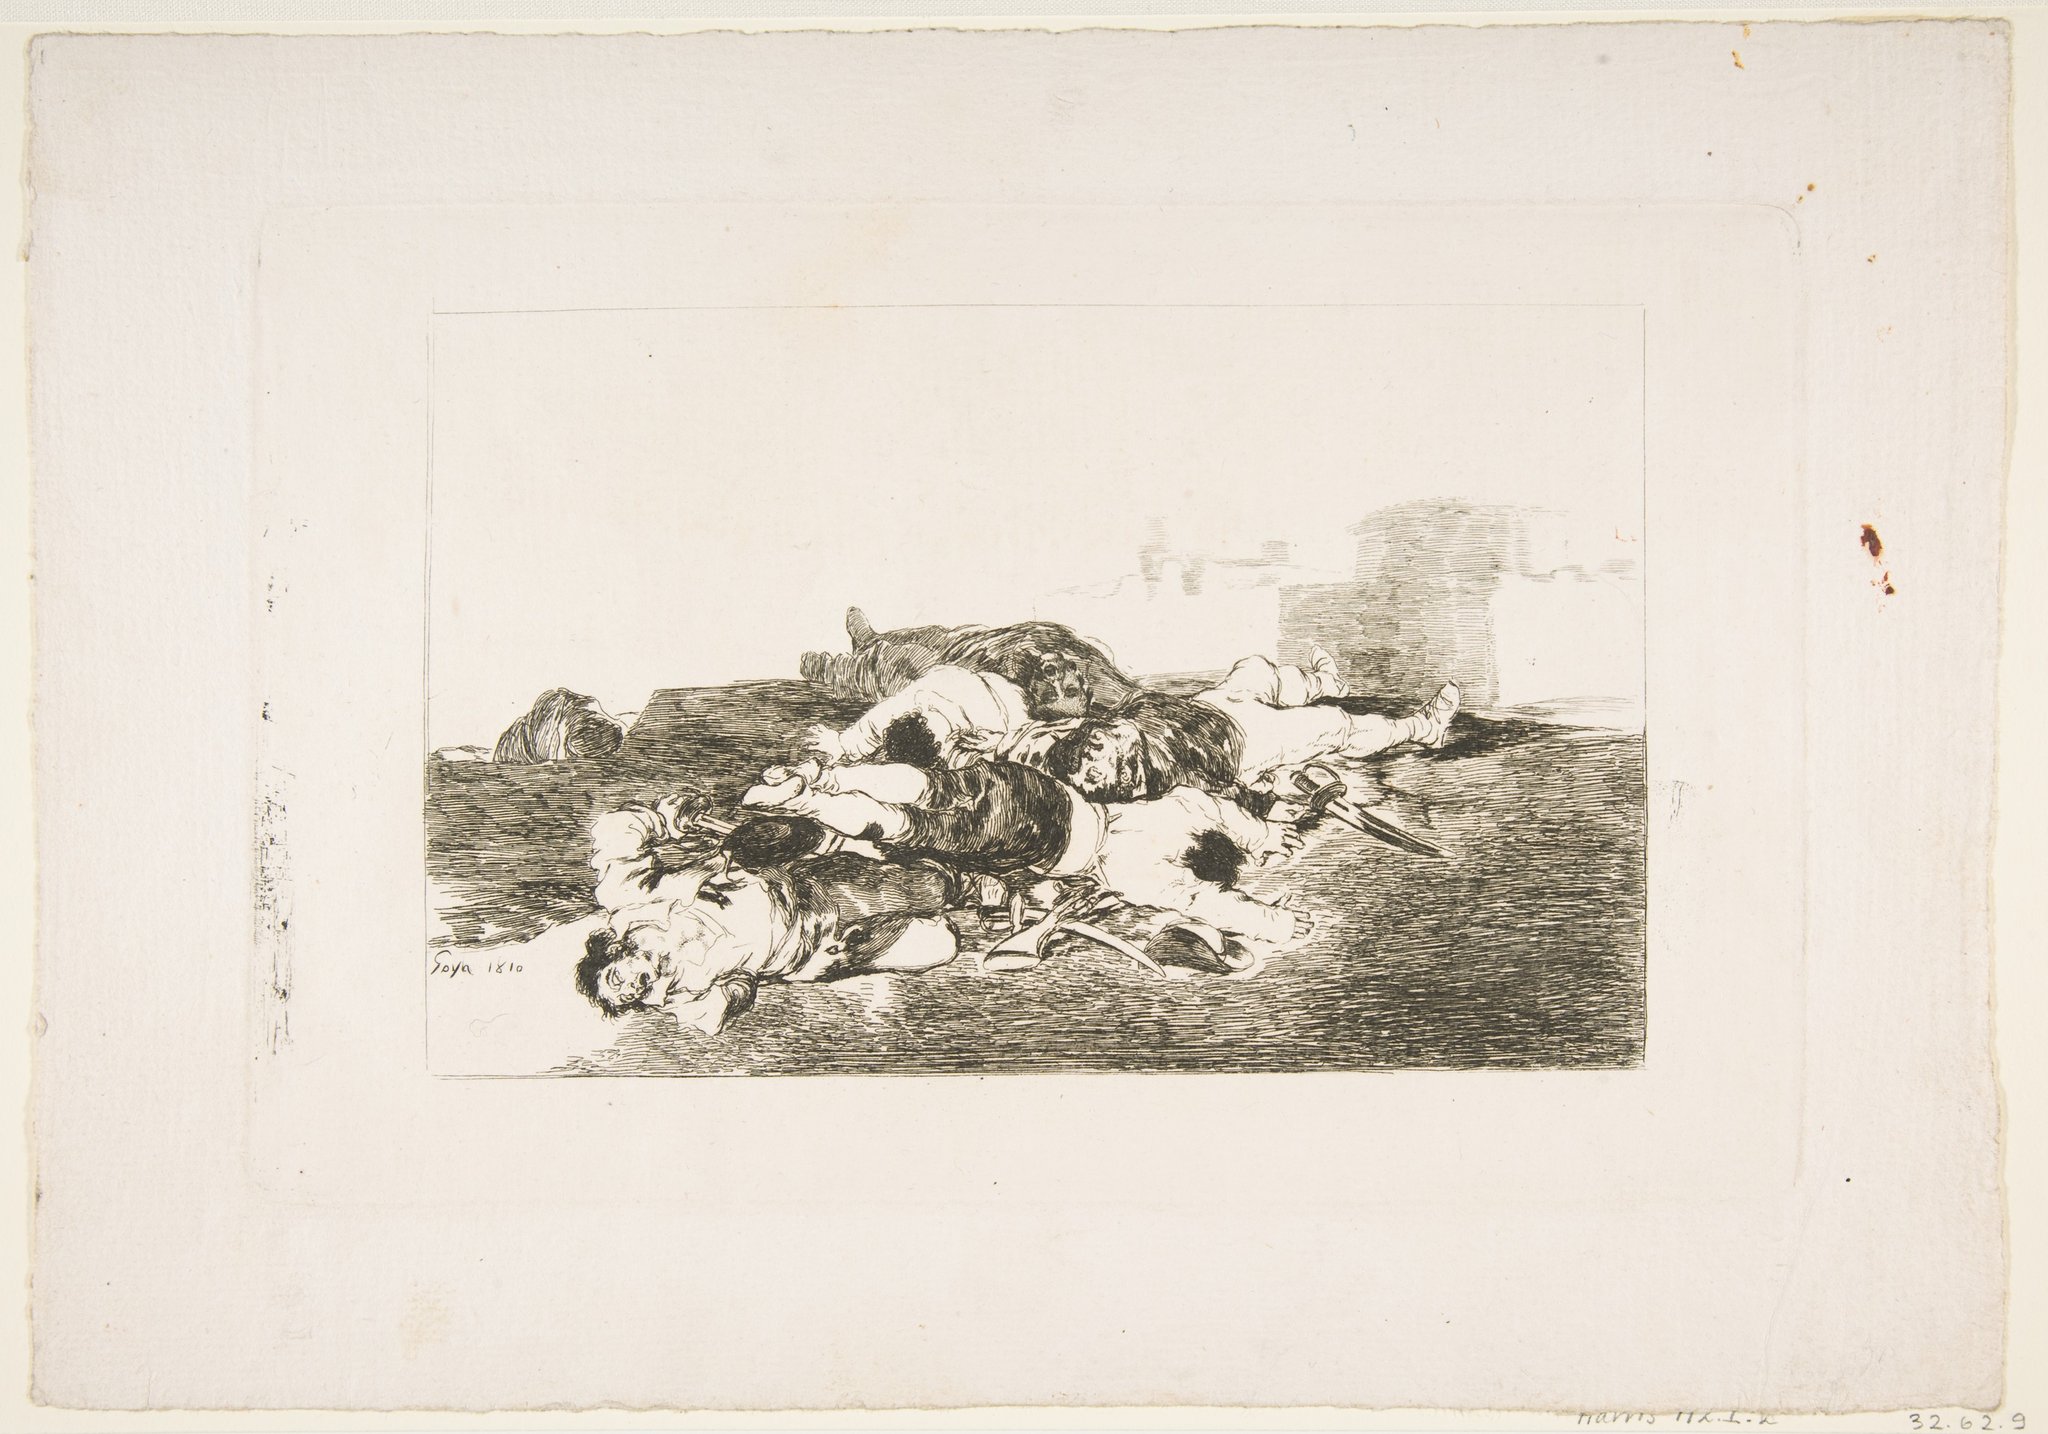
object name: print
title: Plate 22 from "The Disasters of War" (Los Desastres de la Guerra): 'Even worse' (Tanto y mas)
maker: goya (francisco de goya y lucientes)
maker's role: artist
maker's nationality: spanish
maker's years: 1746-1828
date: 1810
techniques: engraving, etching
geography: spain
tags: men,death